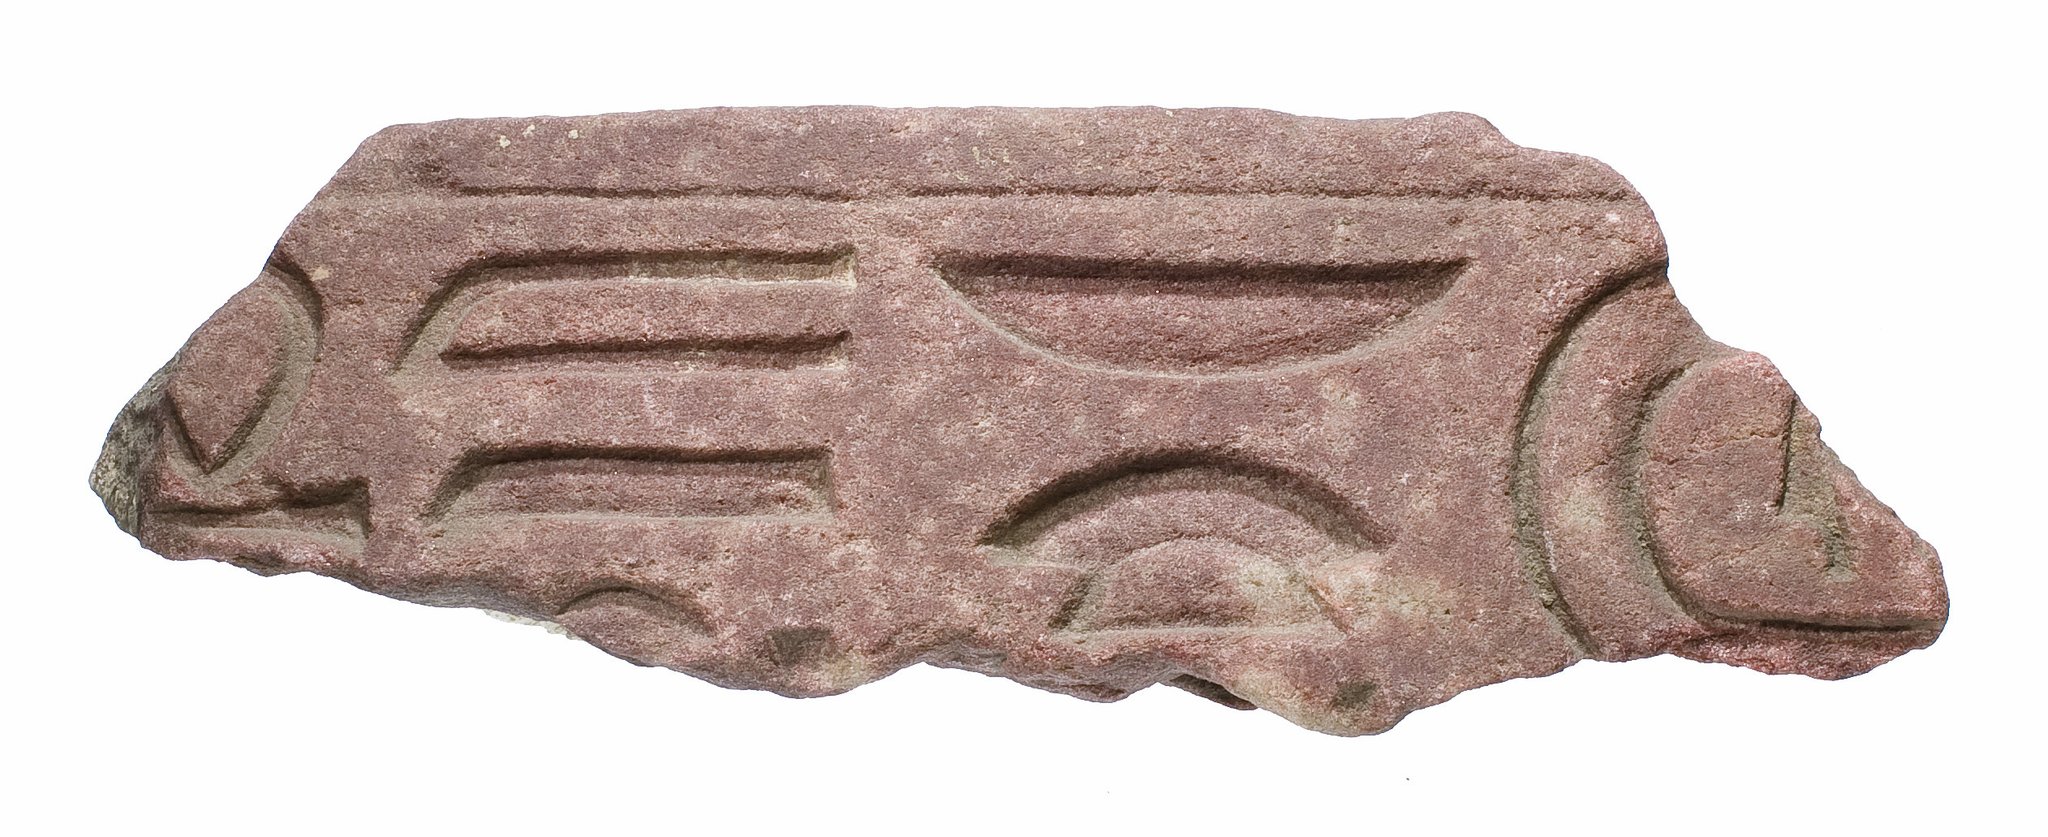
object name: name and part of titulary of akhenaten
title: Element with part of cartouche and titulary of Akhenaten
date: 1353-1336 BCE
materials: quartzite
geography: egypt